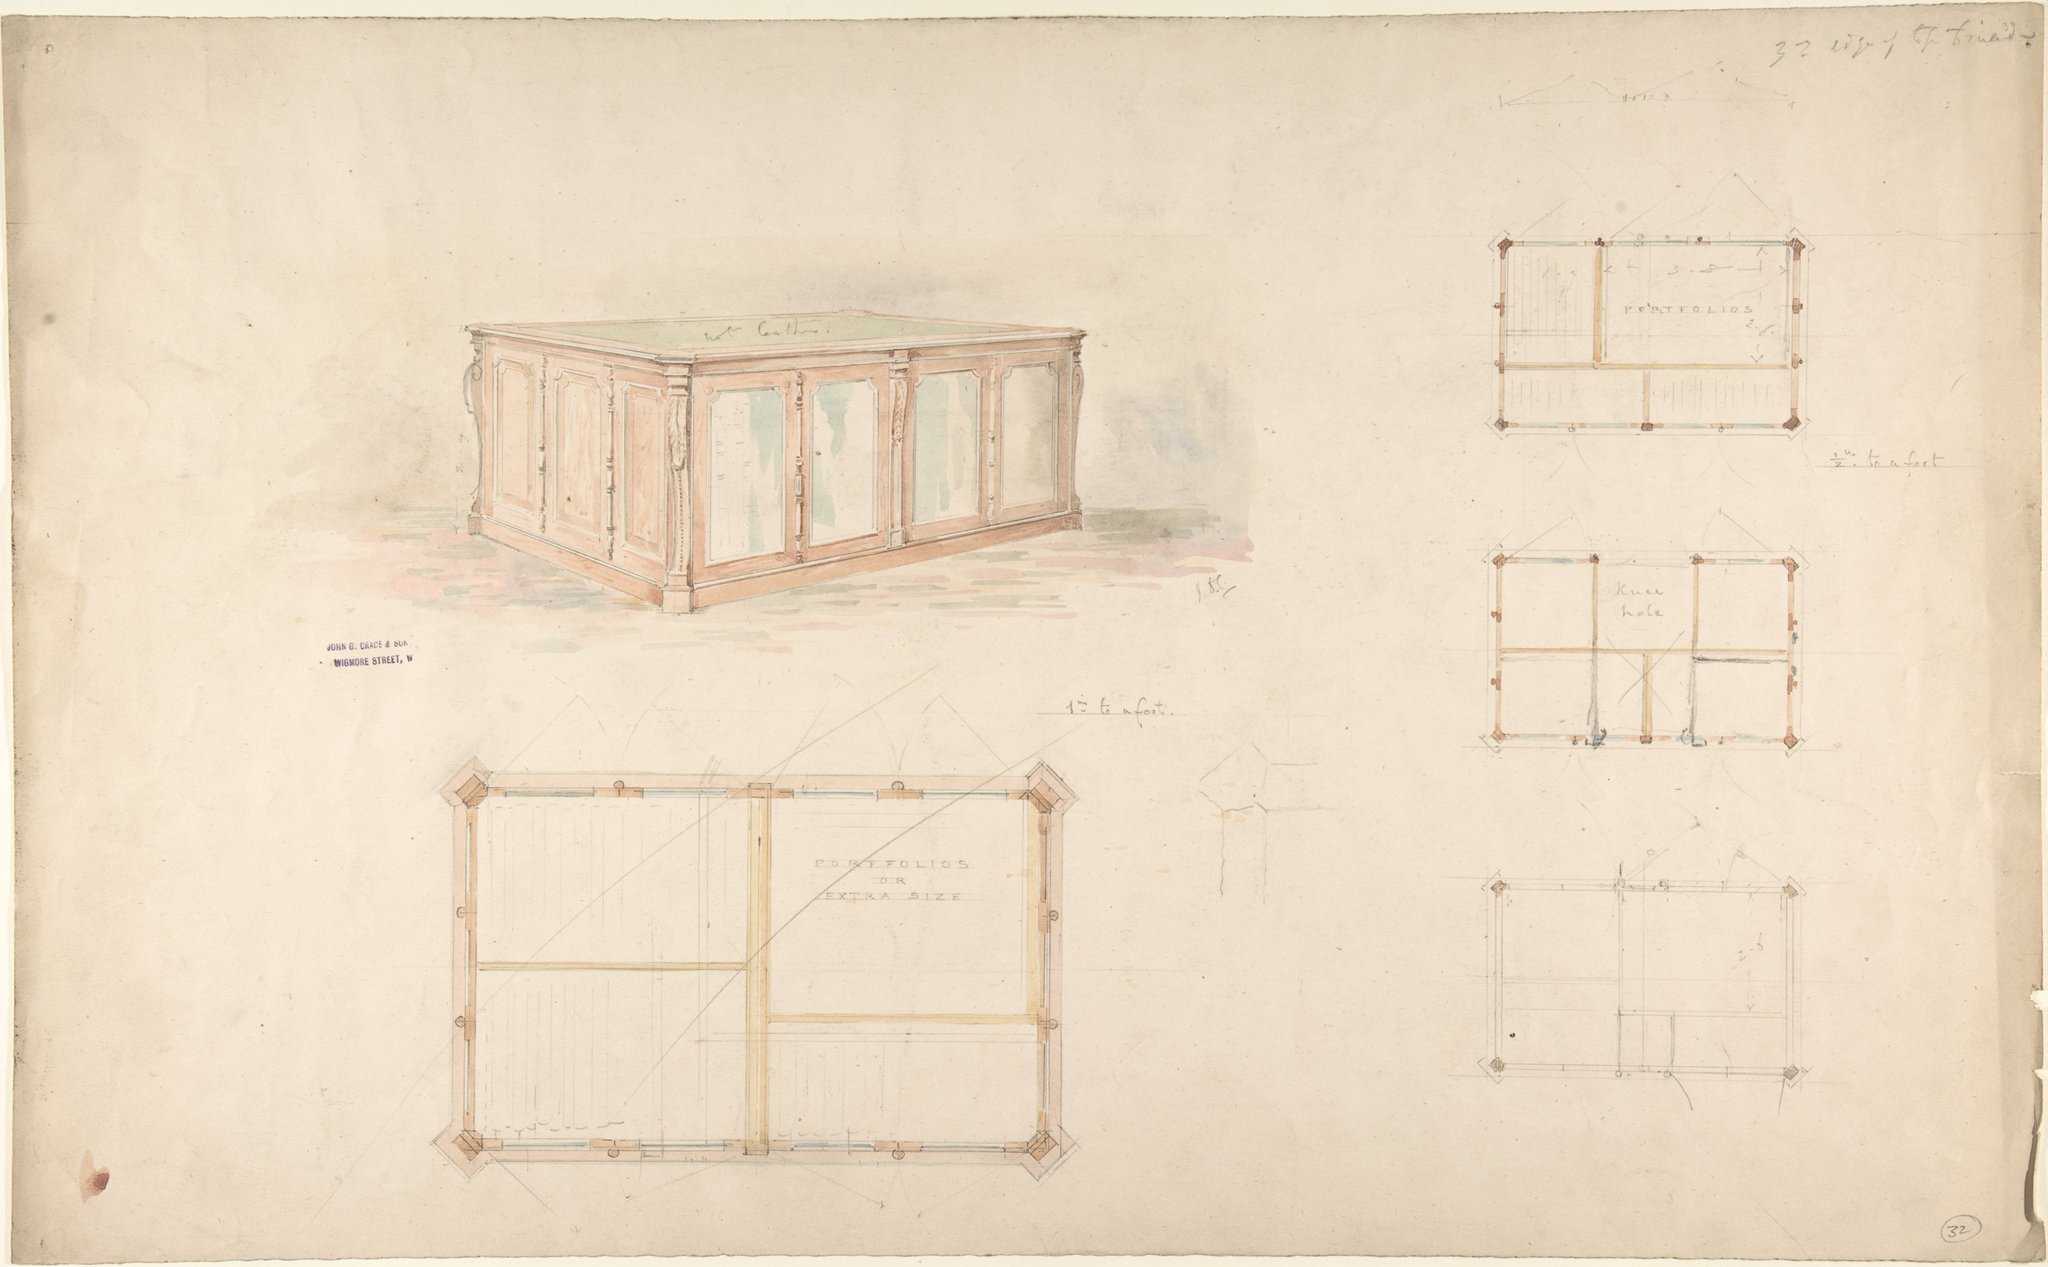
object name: drawing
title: Design for desk and/or portfolio cabinet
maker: john gregory crace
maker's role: artist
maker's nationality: british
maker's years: 1809-1889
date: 1801-1900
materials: graphite, watercolor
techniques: brush, wash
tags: furniture